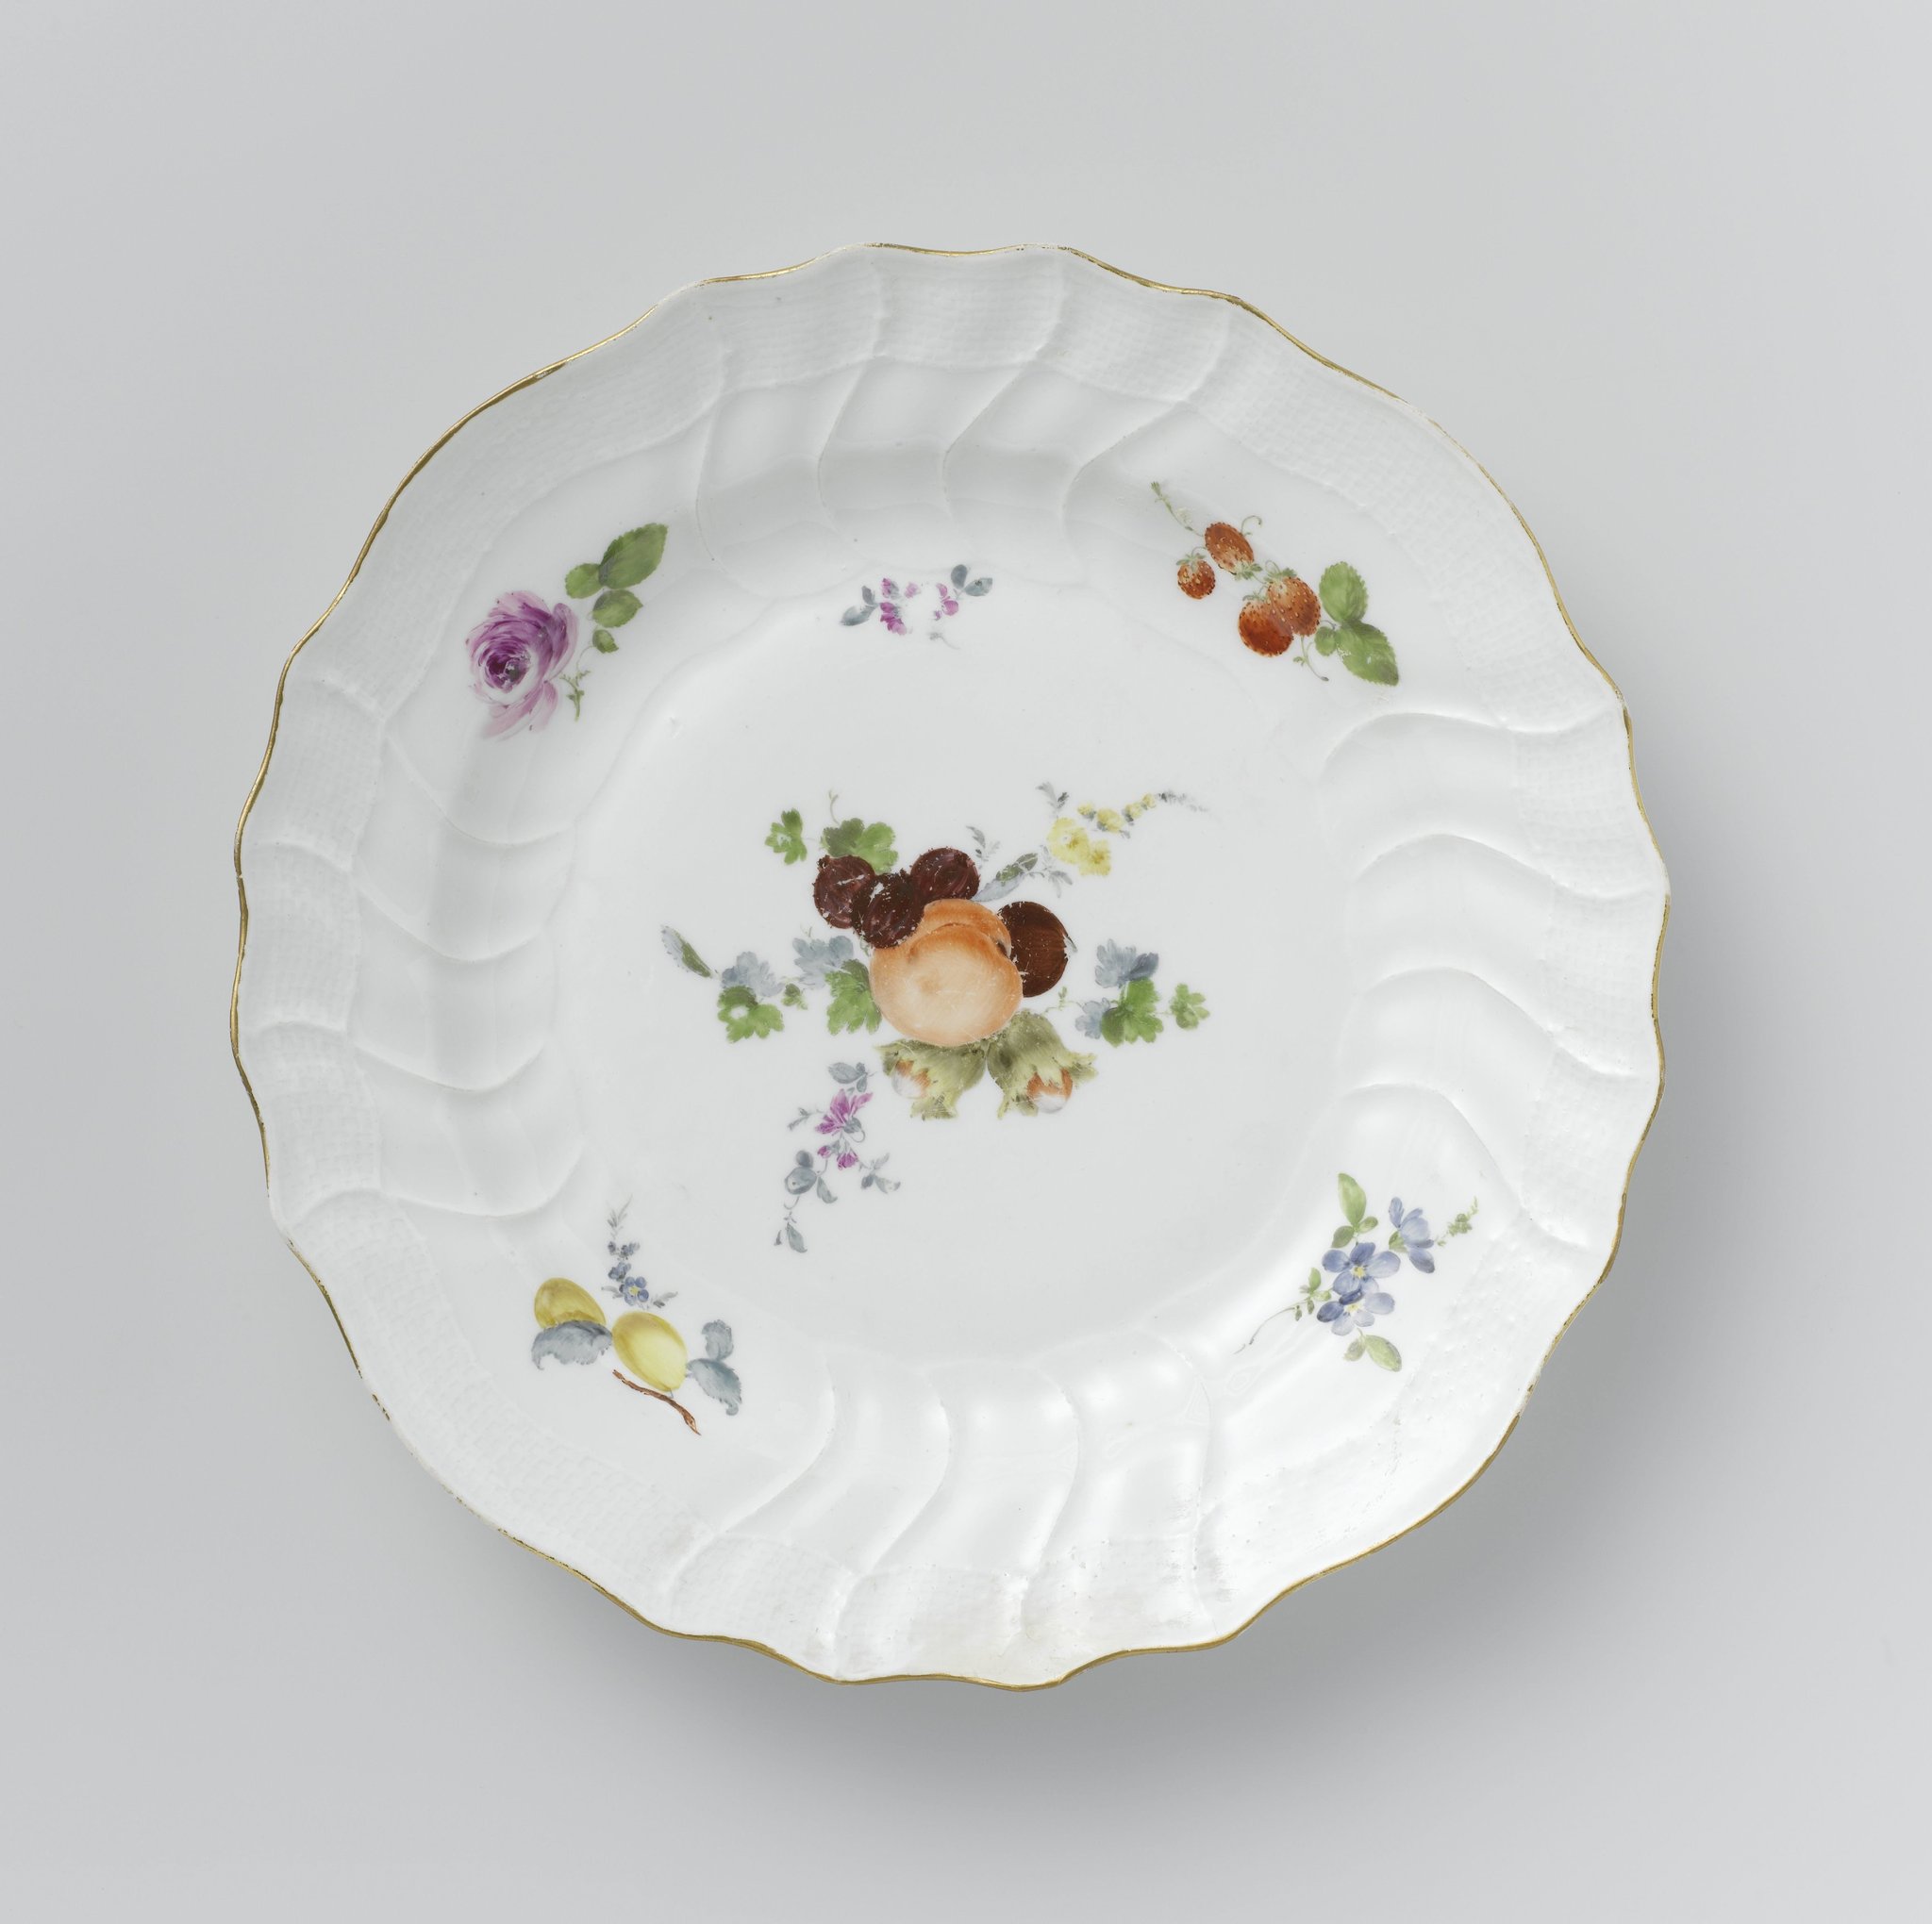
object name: plate dish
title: Bord, veelkleurig beschilderd met Deutsche Blumen, insekten en vruchten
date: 1750-1760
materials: porcelain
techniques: painted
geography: meissen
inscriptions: factory mark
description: Rond bord van beschilderd porselein. Het bord is beschilderd met Deutsche Blumen, insekten en vruchten. De rand is in reliëf versierd met het Neuozier-patroon. Het bord is gemerkt en hoort bij een servies (BK-17474-1 t/m BK-17474-253).